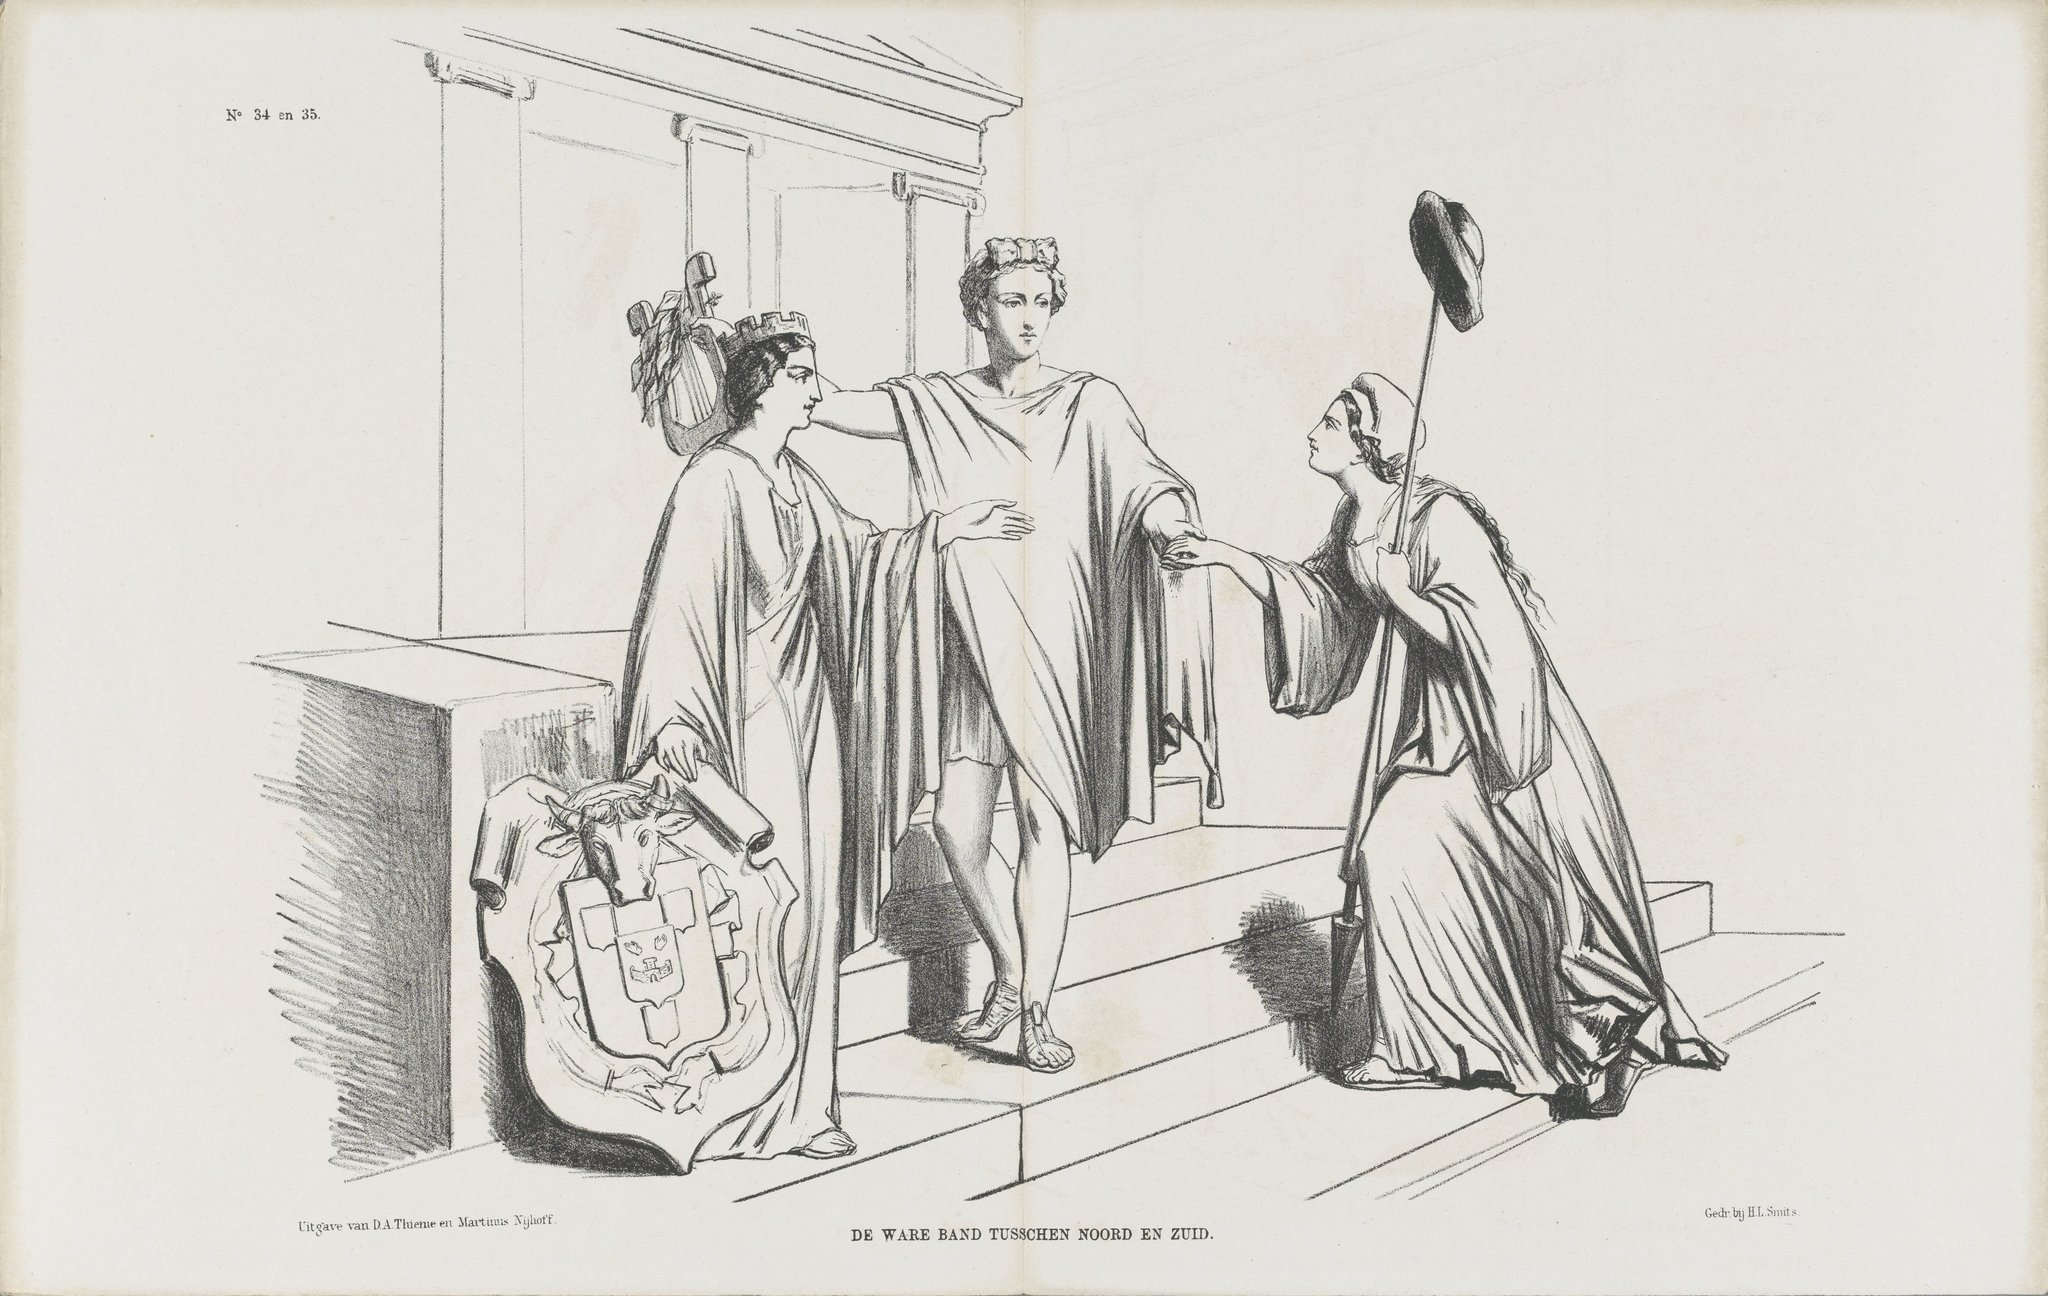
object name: print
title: Allegorie op Antwerpse kunstfeesten, 1861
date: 1861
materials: paper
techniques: lithograph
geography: netherlands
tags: personifications of countries, nations, states, districts, etc., personification of a city, town-patron(ess), specific aspects, allegorical aspects of apollo; apollo as patron, antwerp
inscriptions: collector's mark: Lugt 2228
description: Apollo introduceert de Nederlandse Maagd aan de stadsmaagd van Antwerpen. In verband met de Antwerpse kunstfeesten. Plaat verschenen bij het weekblad De Nederlandsche Spectator, nr. 34 en 35, 31 augustus 1861.